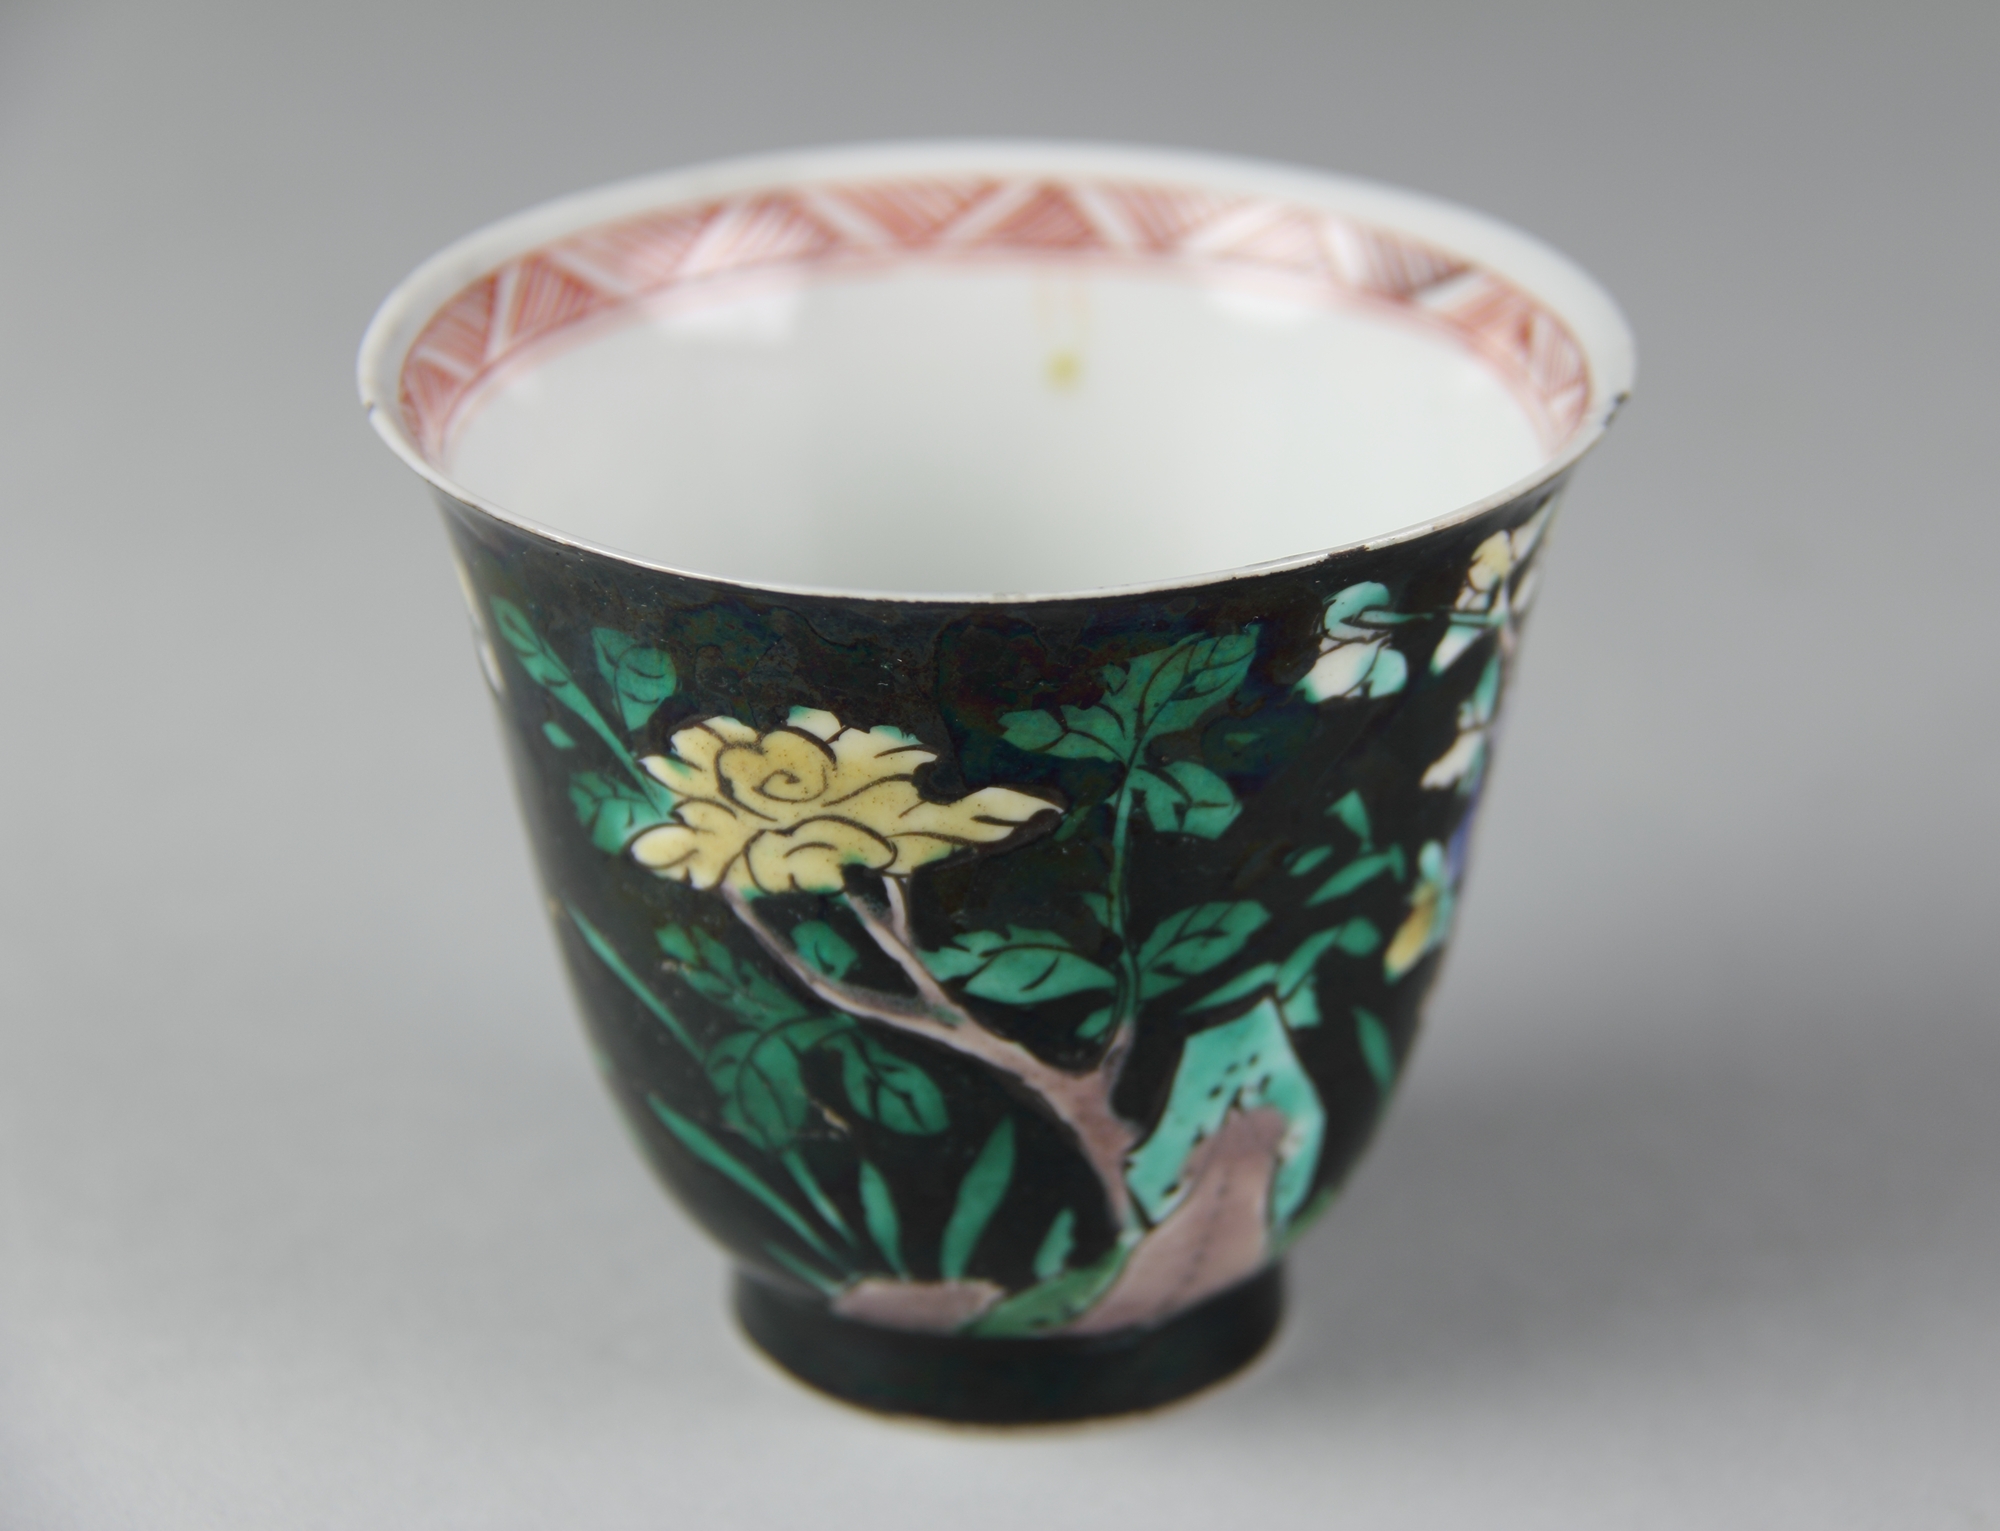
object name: cup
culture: chinese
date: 1662-1722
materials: porcelain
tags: flowers,leaves